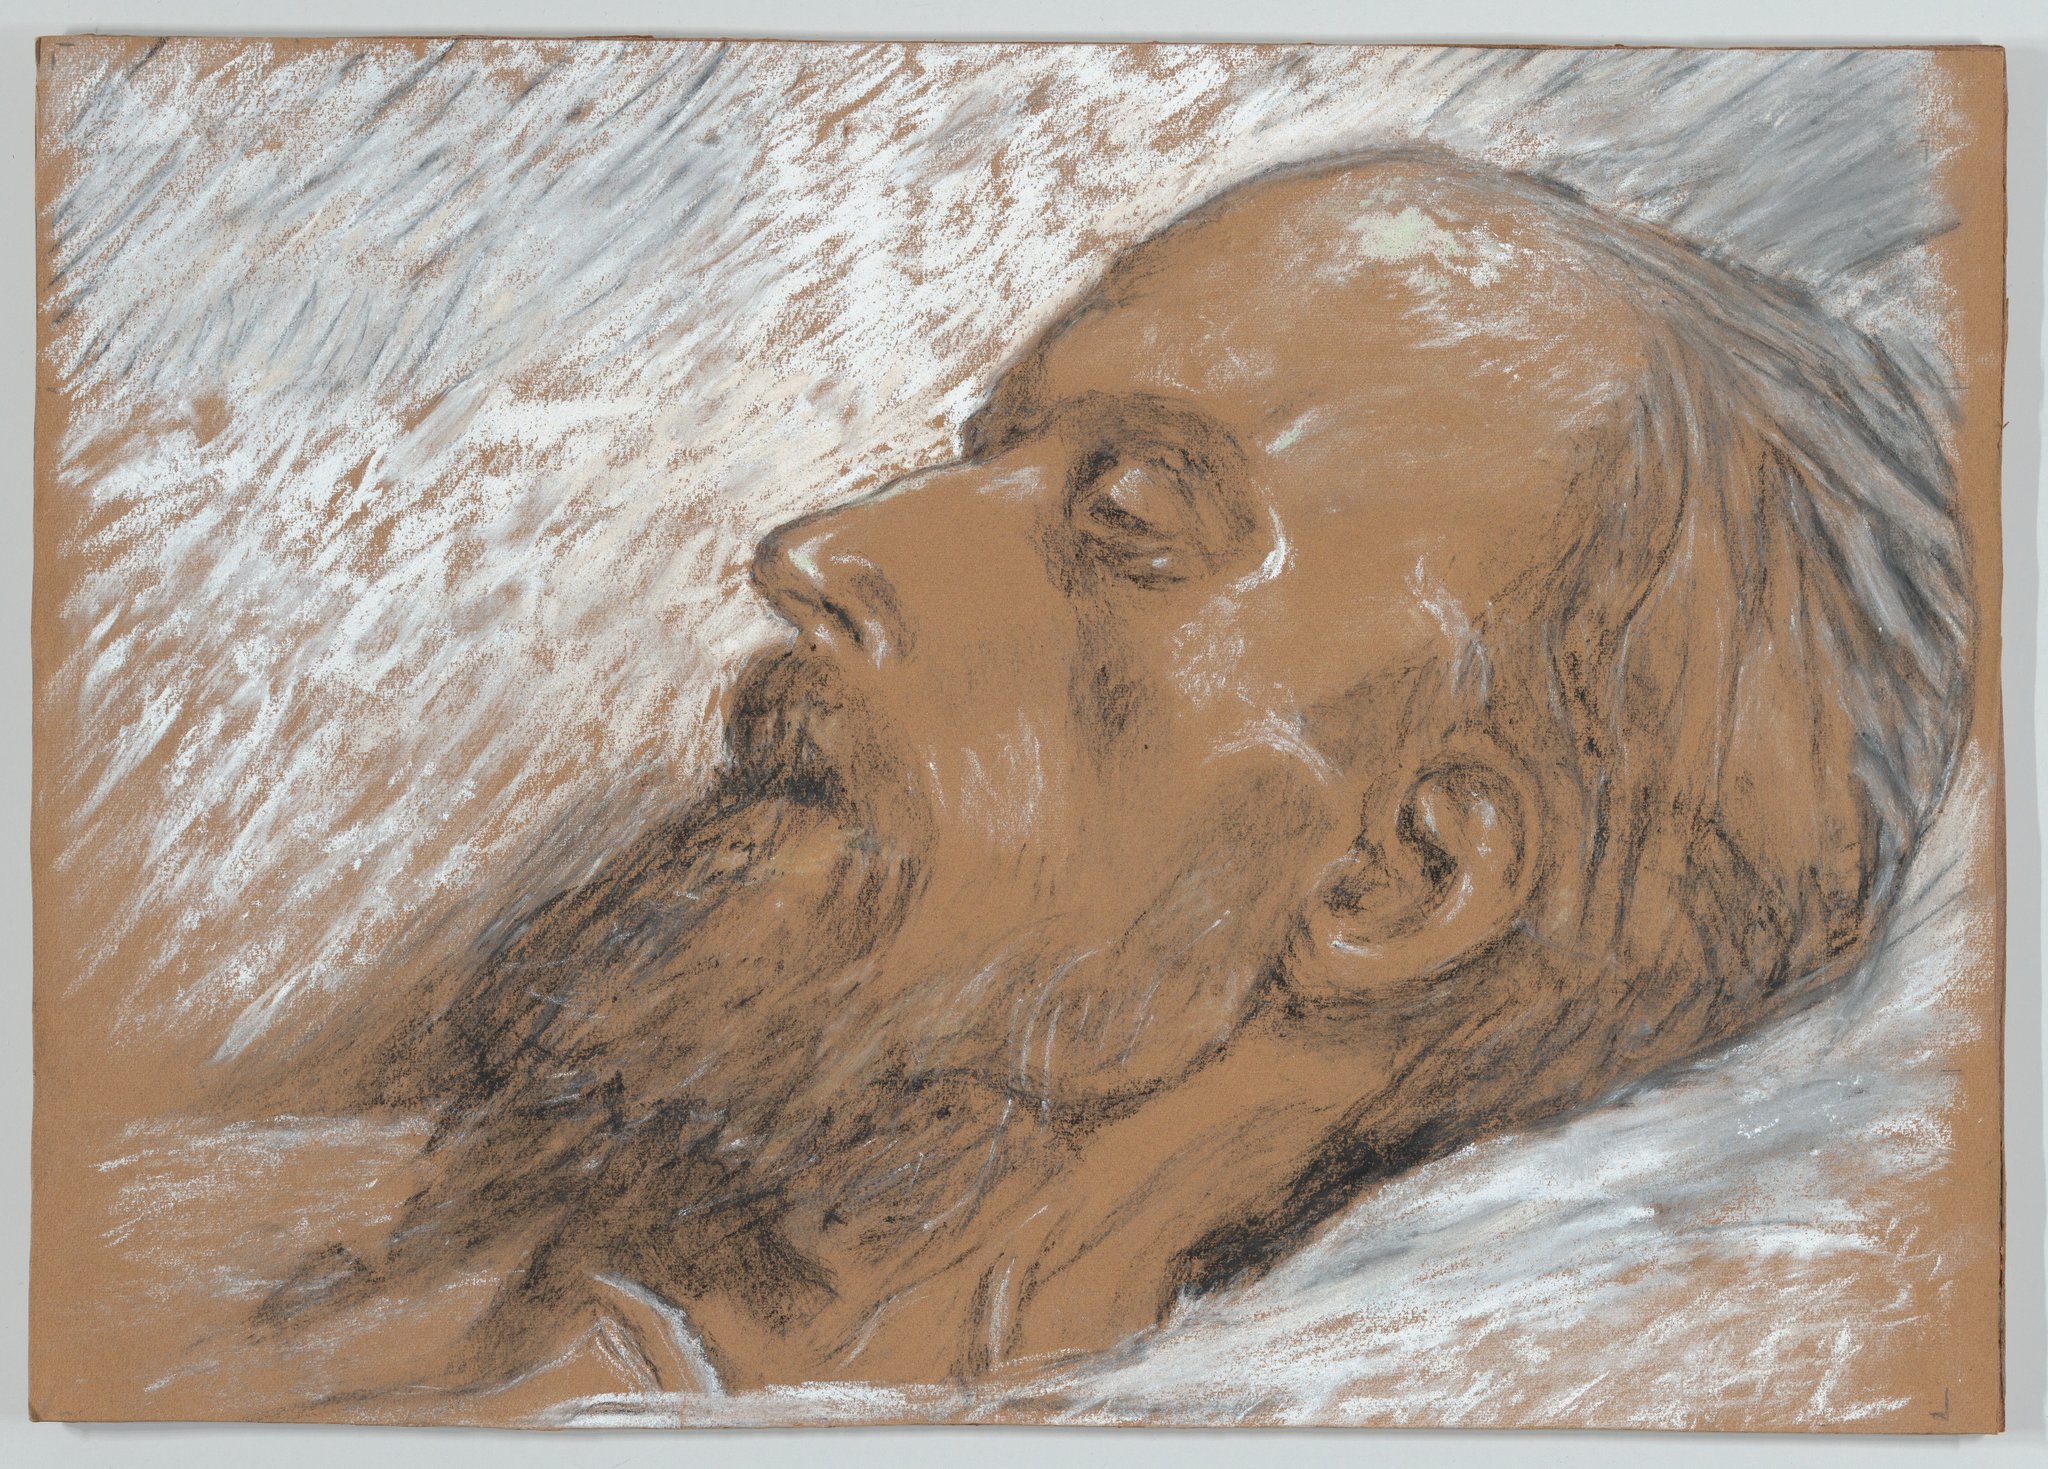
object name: drawing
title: Manet on His Deathbed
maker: pierre-ernest prins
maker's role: artist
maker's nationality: french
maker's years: 1838-1913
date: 1883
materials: pastel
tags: heads,men,death